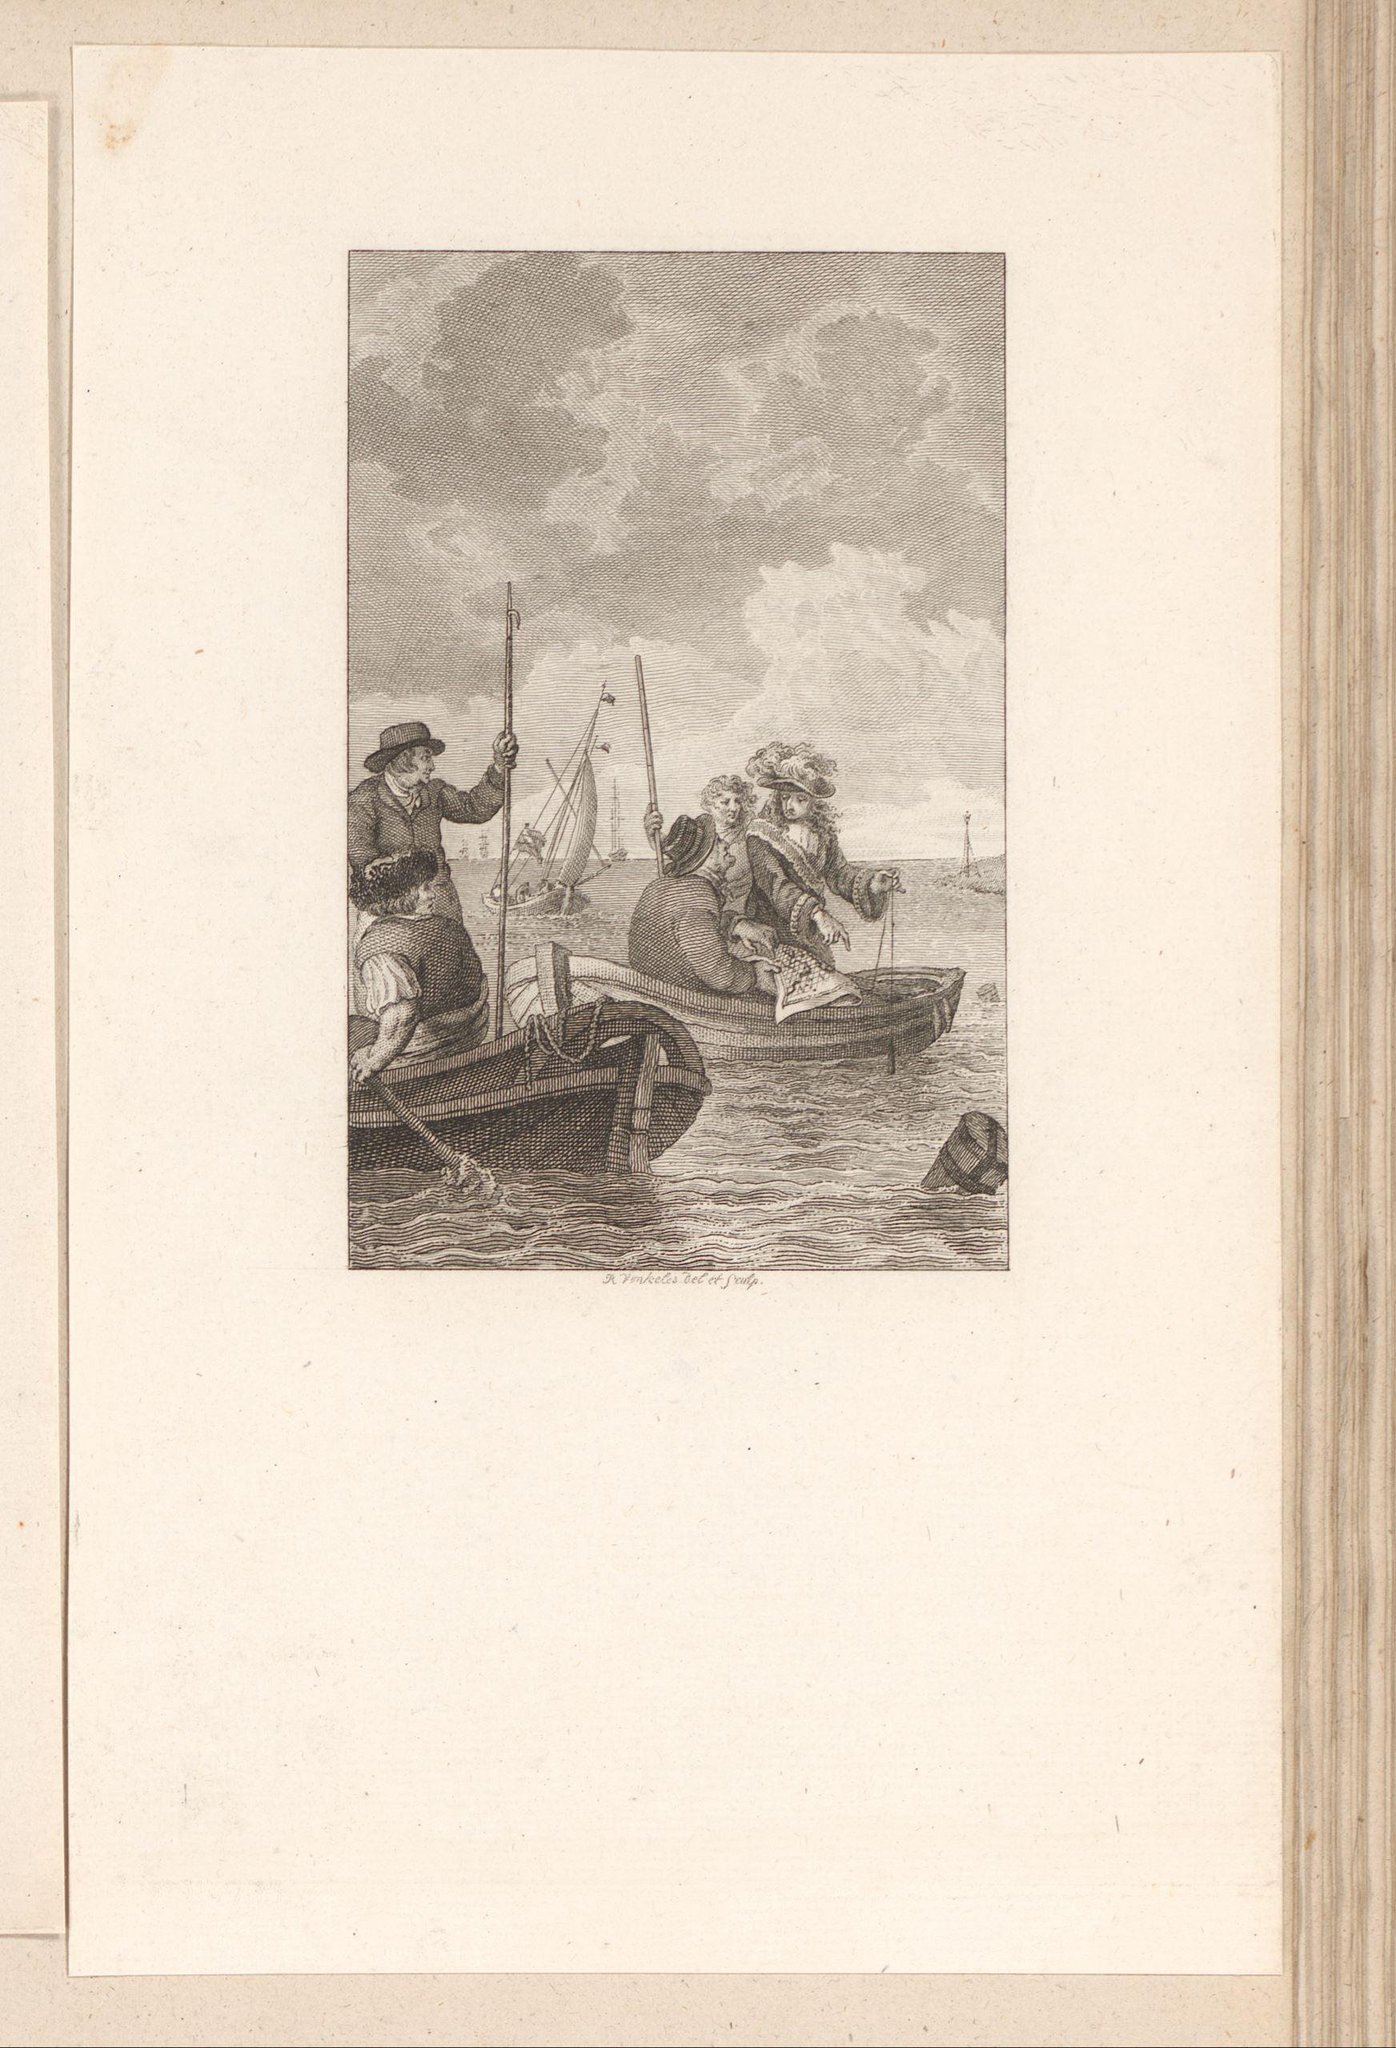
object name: book illustration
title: Johan de Witt in een roeiboot op het Spaanse gat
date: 1805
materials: paper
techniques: engraving, etching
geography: amsterdam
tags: the hague, politician, johan de witt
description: Proefdruk van een boekillustratie gebruikt in: Loosjes Pietersz., Adriaan. Johan de Witt. Raadpensionaris van Holland. Haarlem: A. Loosjes, 1805.